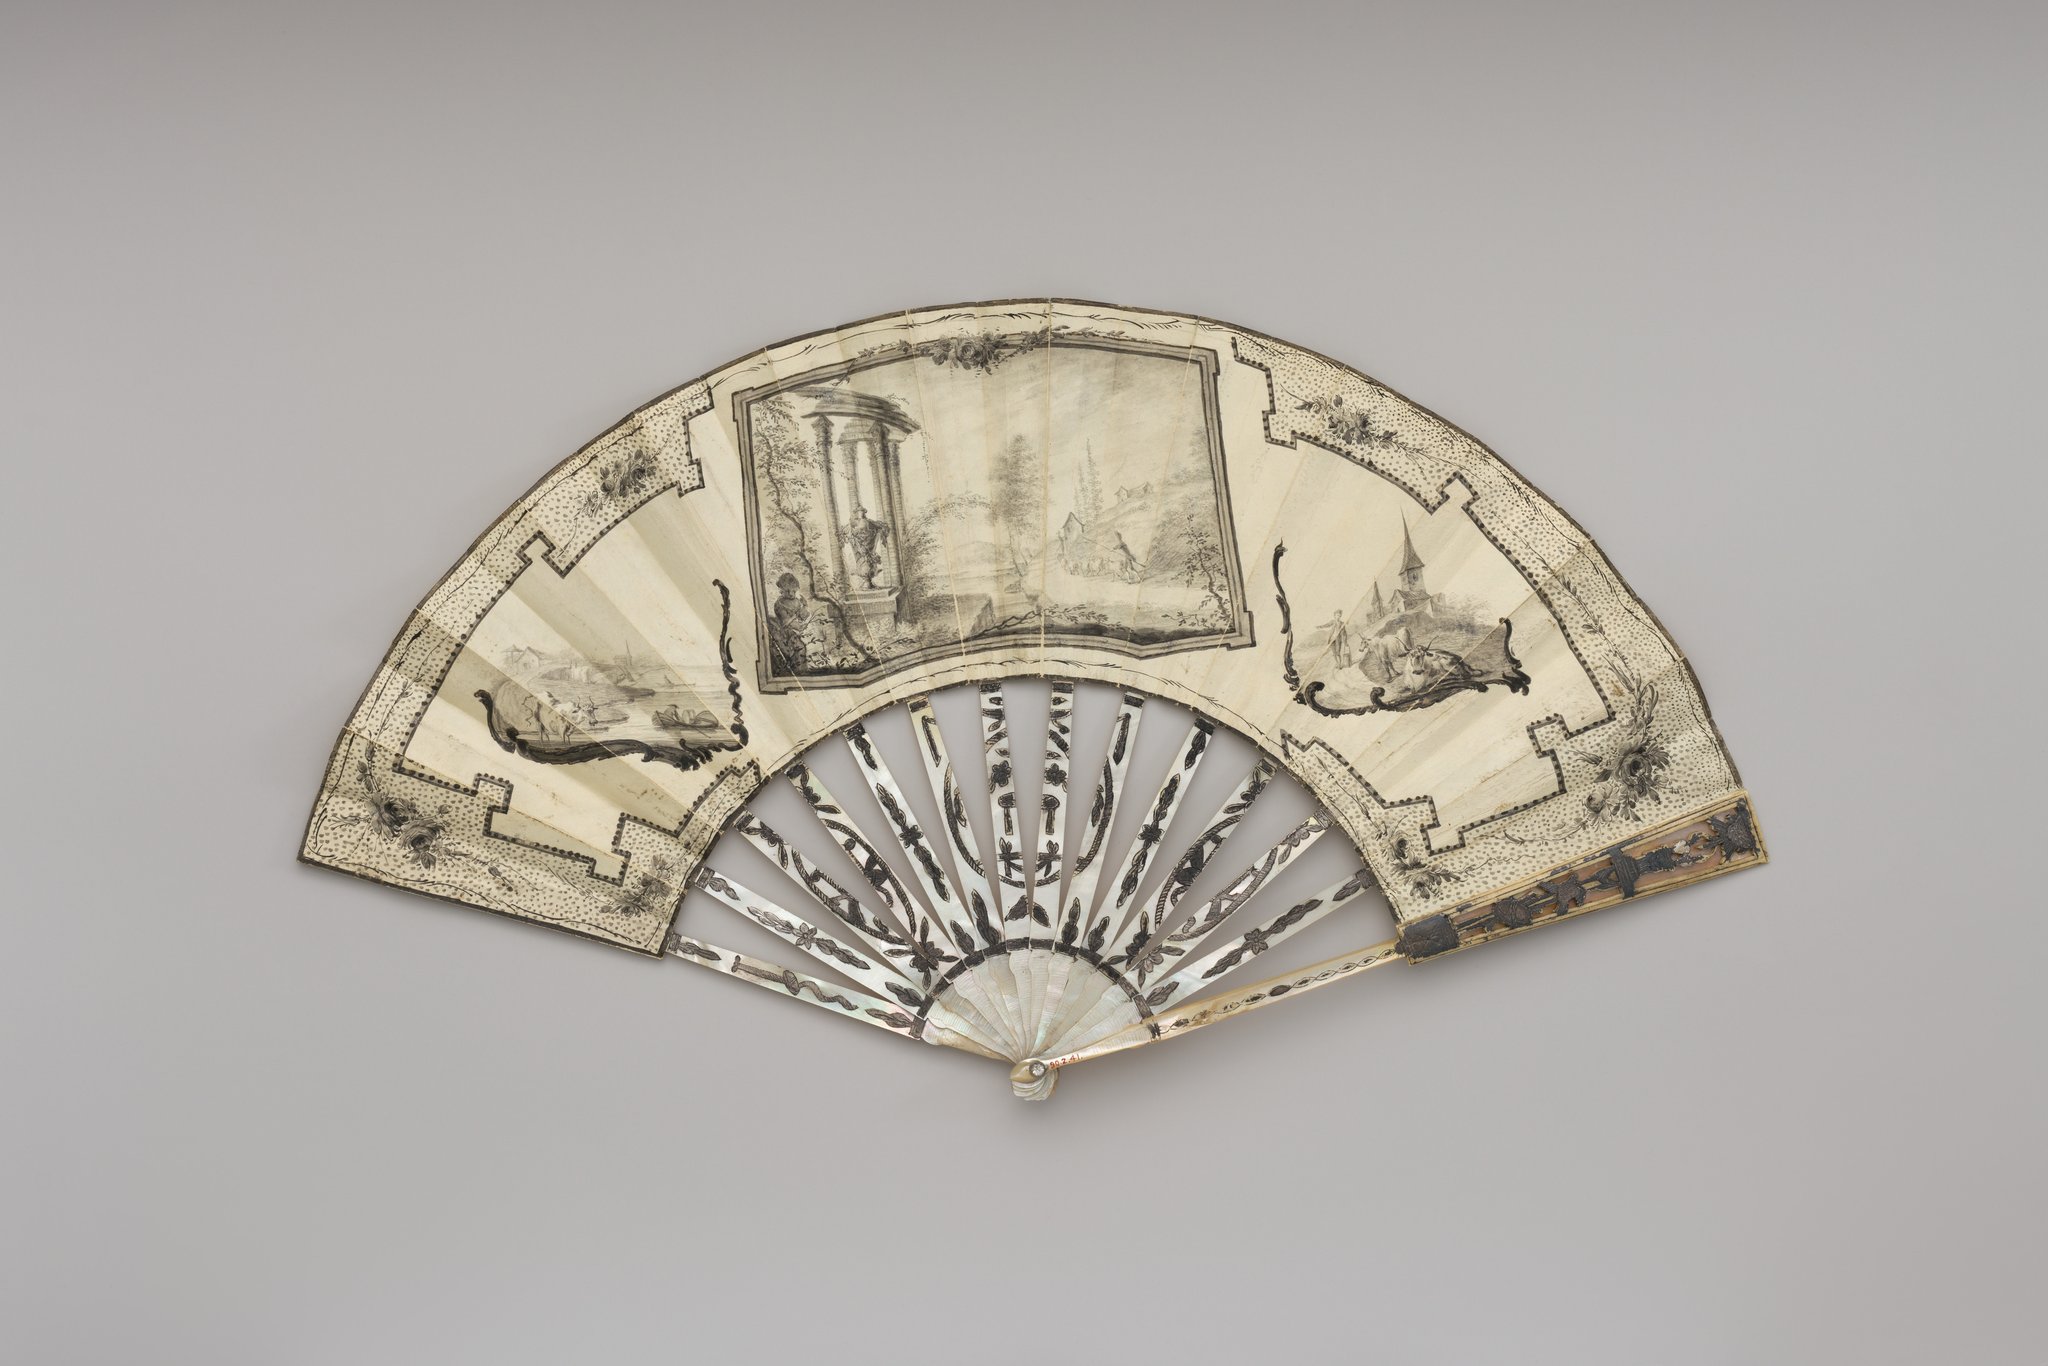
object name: fan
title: Mourning fan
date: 1770-1790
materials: ink, mother of pearl, silver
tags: men,landscapes